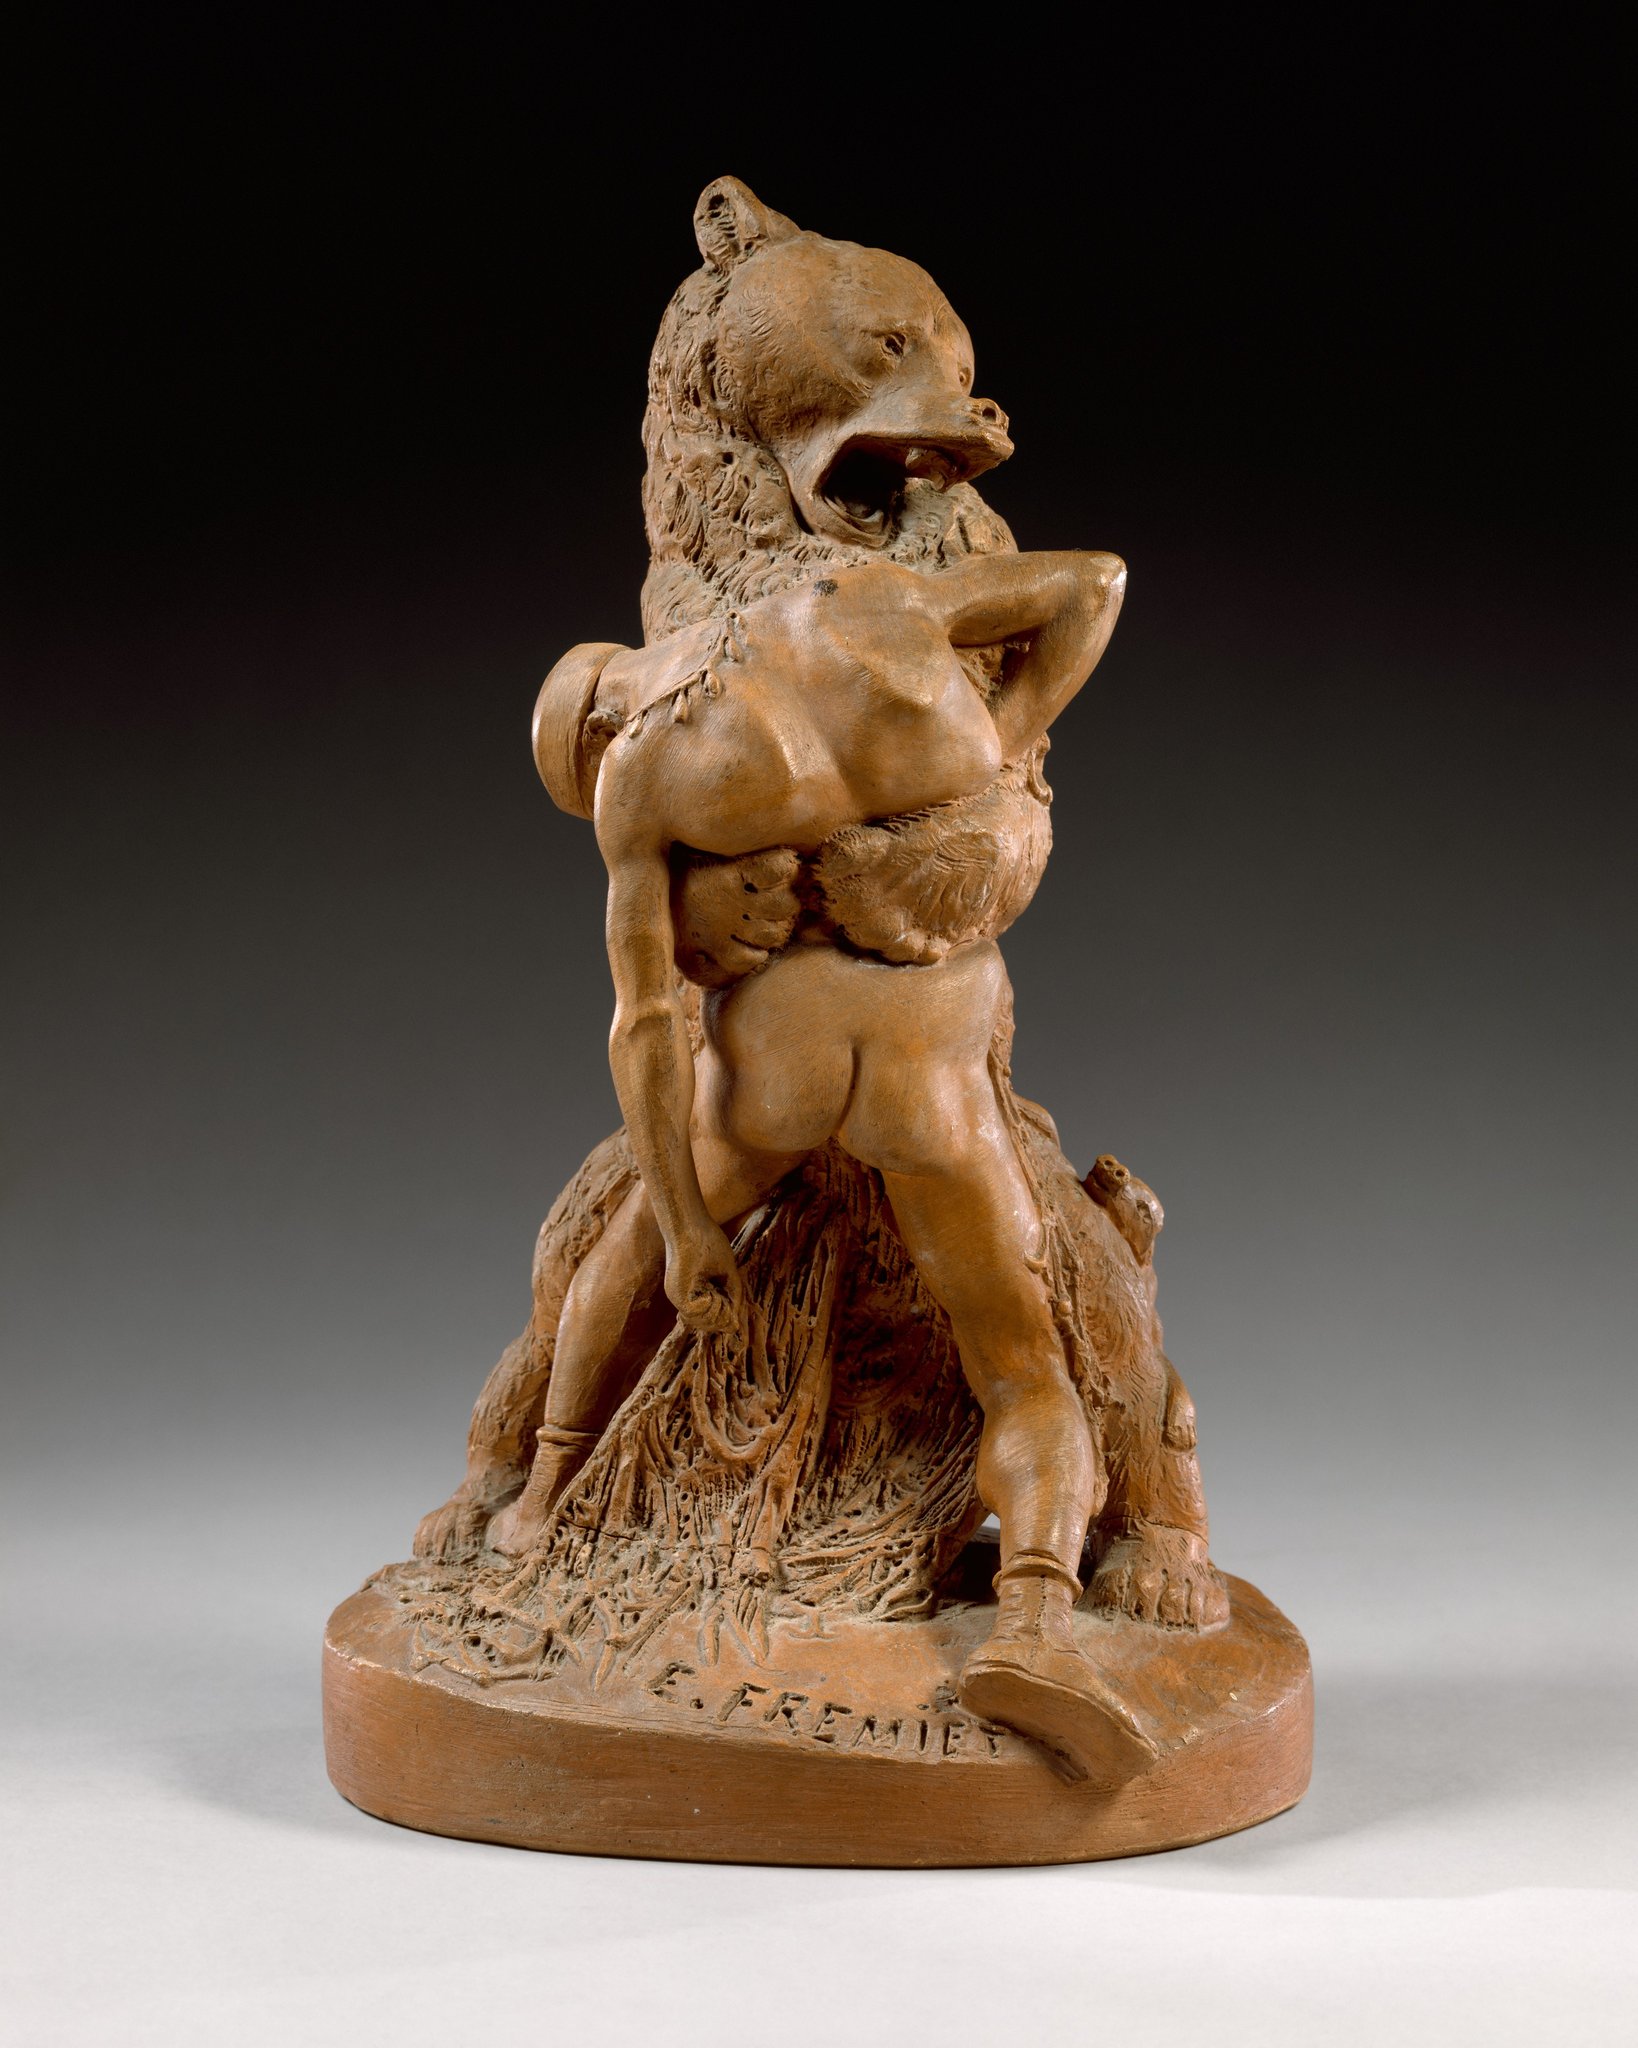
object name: statuette group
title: The Wounded Bear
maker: emmanuel frémiet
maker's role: artist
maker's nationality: french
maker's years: 1824-1910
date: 1850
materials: terracotta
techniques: casting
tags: human figures,bears